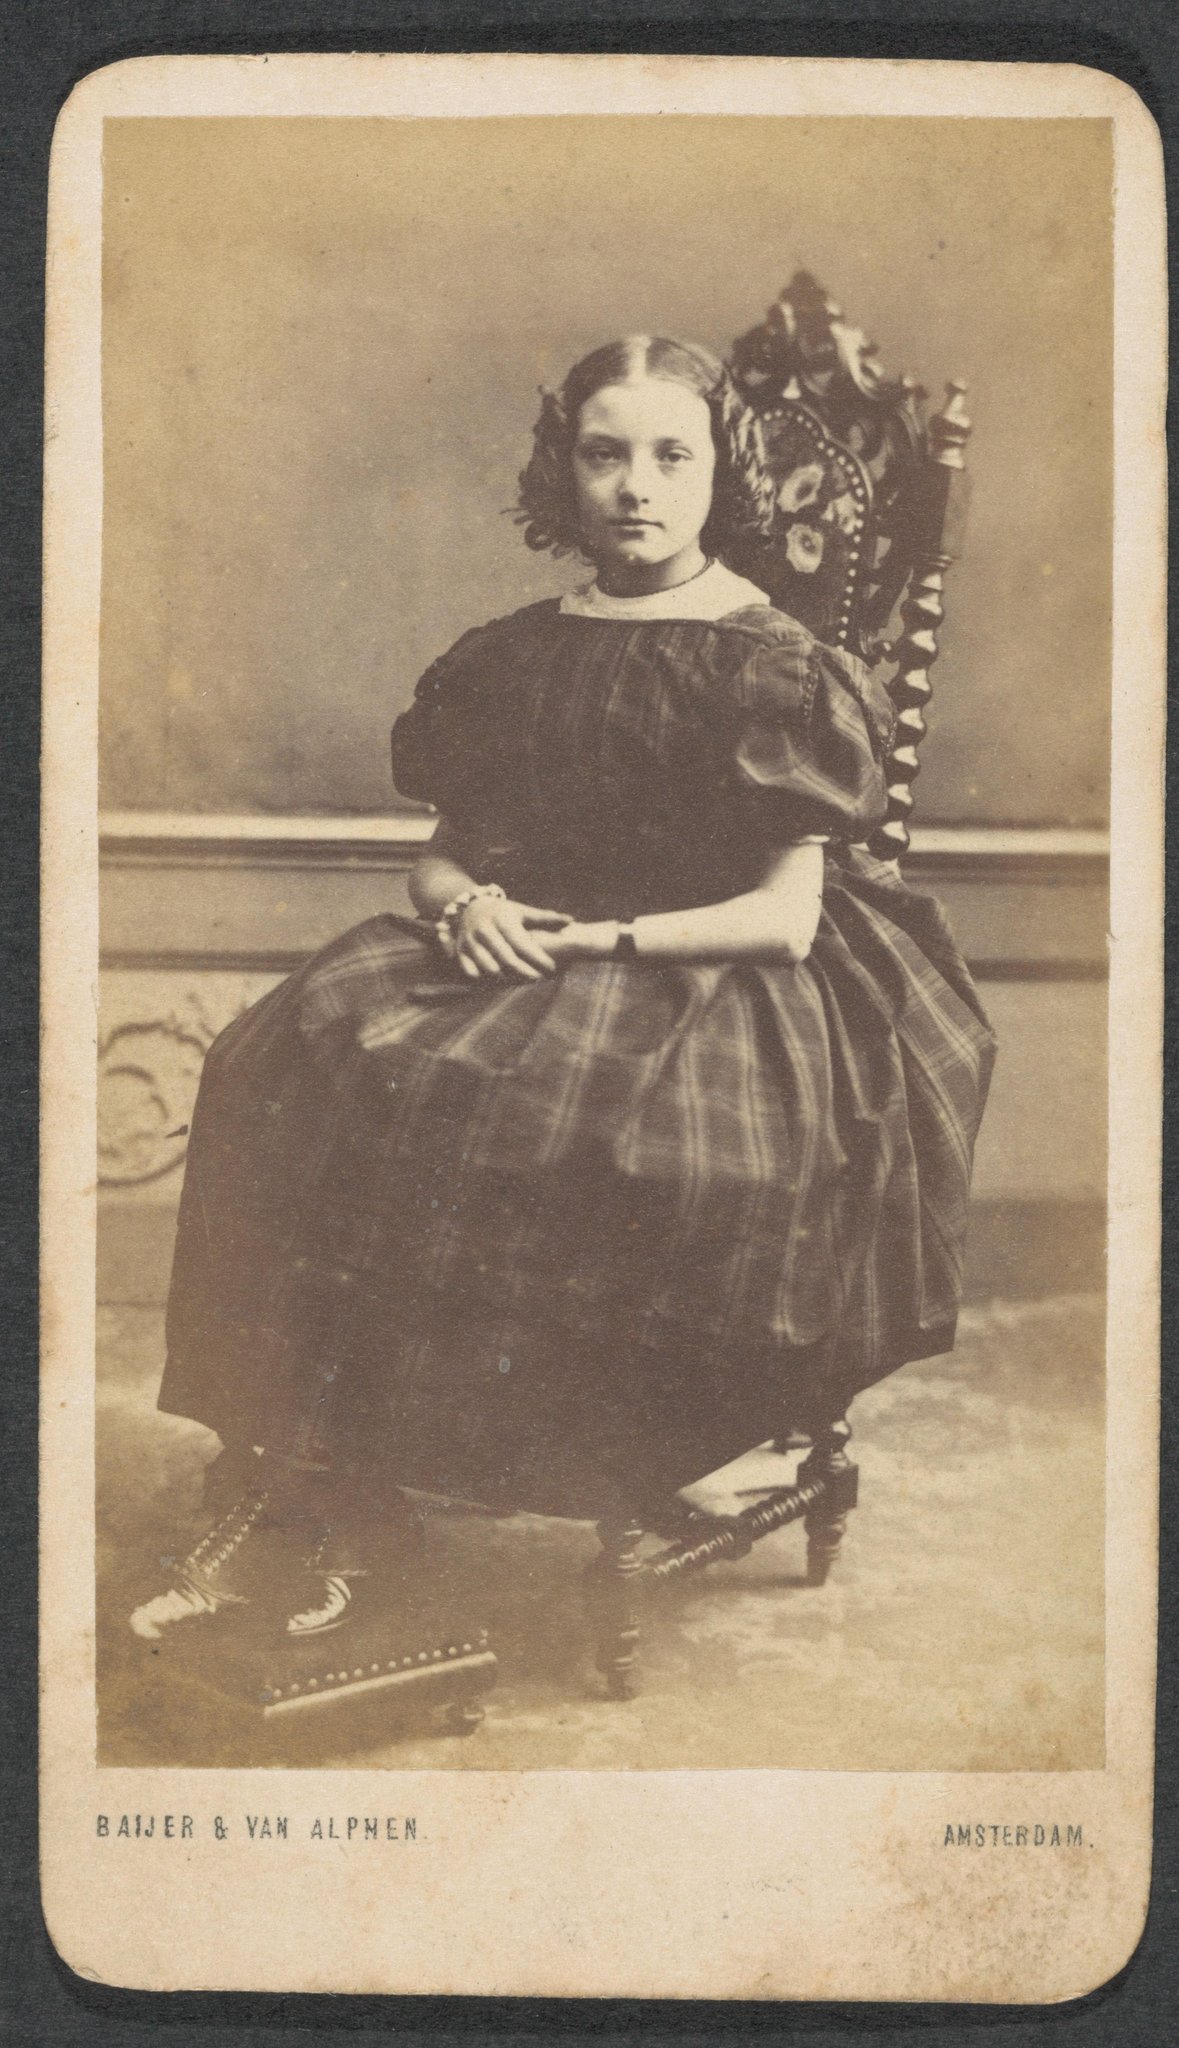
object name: photograph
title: Portret van een onbekend meisje uit de familie Marmelstein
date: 1873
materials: cardboard, photographic support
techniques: albumen print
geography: amsterdam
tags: adolescent, young woman, maiden, historical persons not known by name - bb - woman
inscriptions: address: ‘Photographisch atelier/ Baijer & Van Alphen/ Haarlemmerdijk U.U. 275 en Doelenstraat B. 87./ Amsterdam’